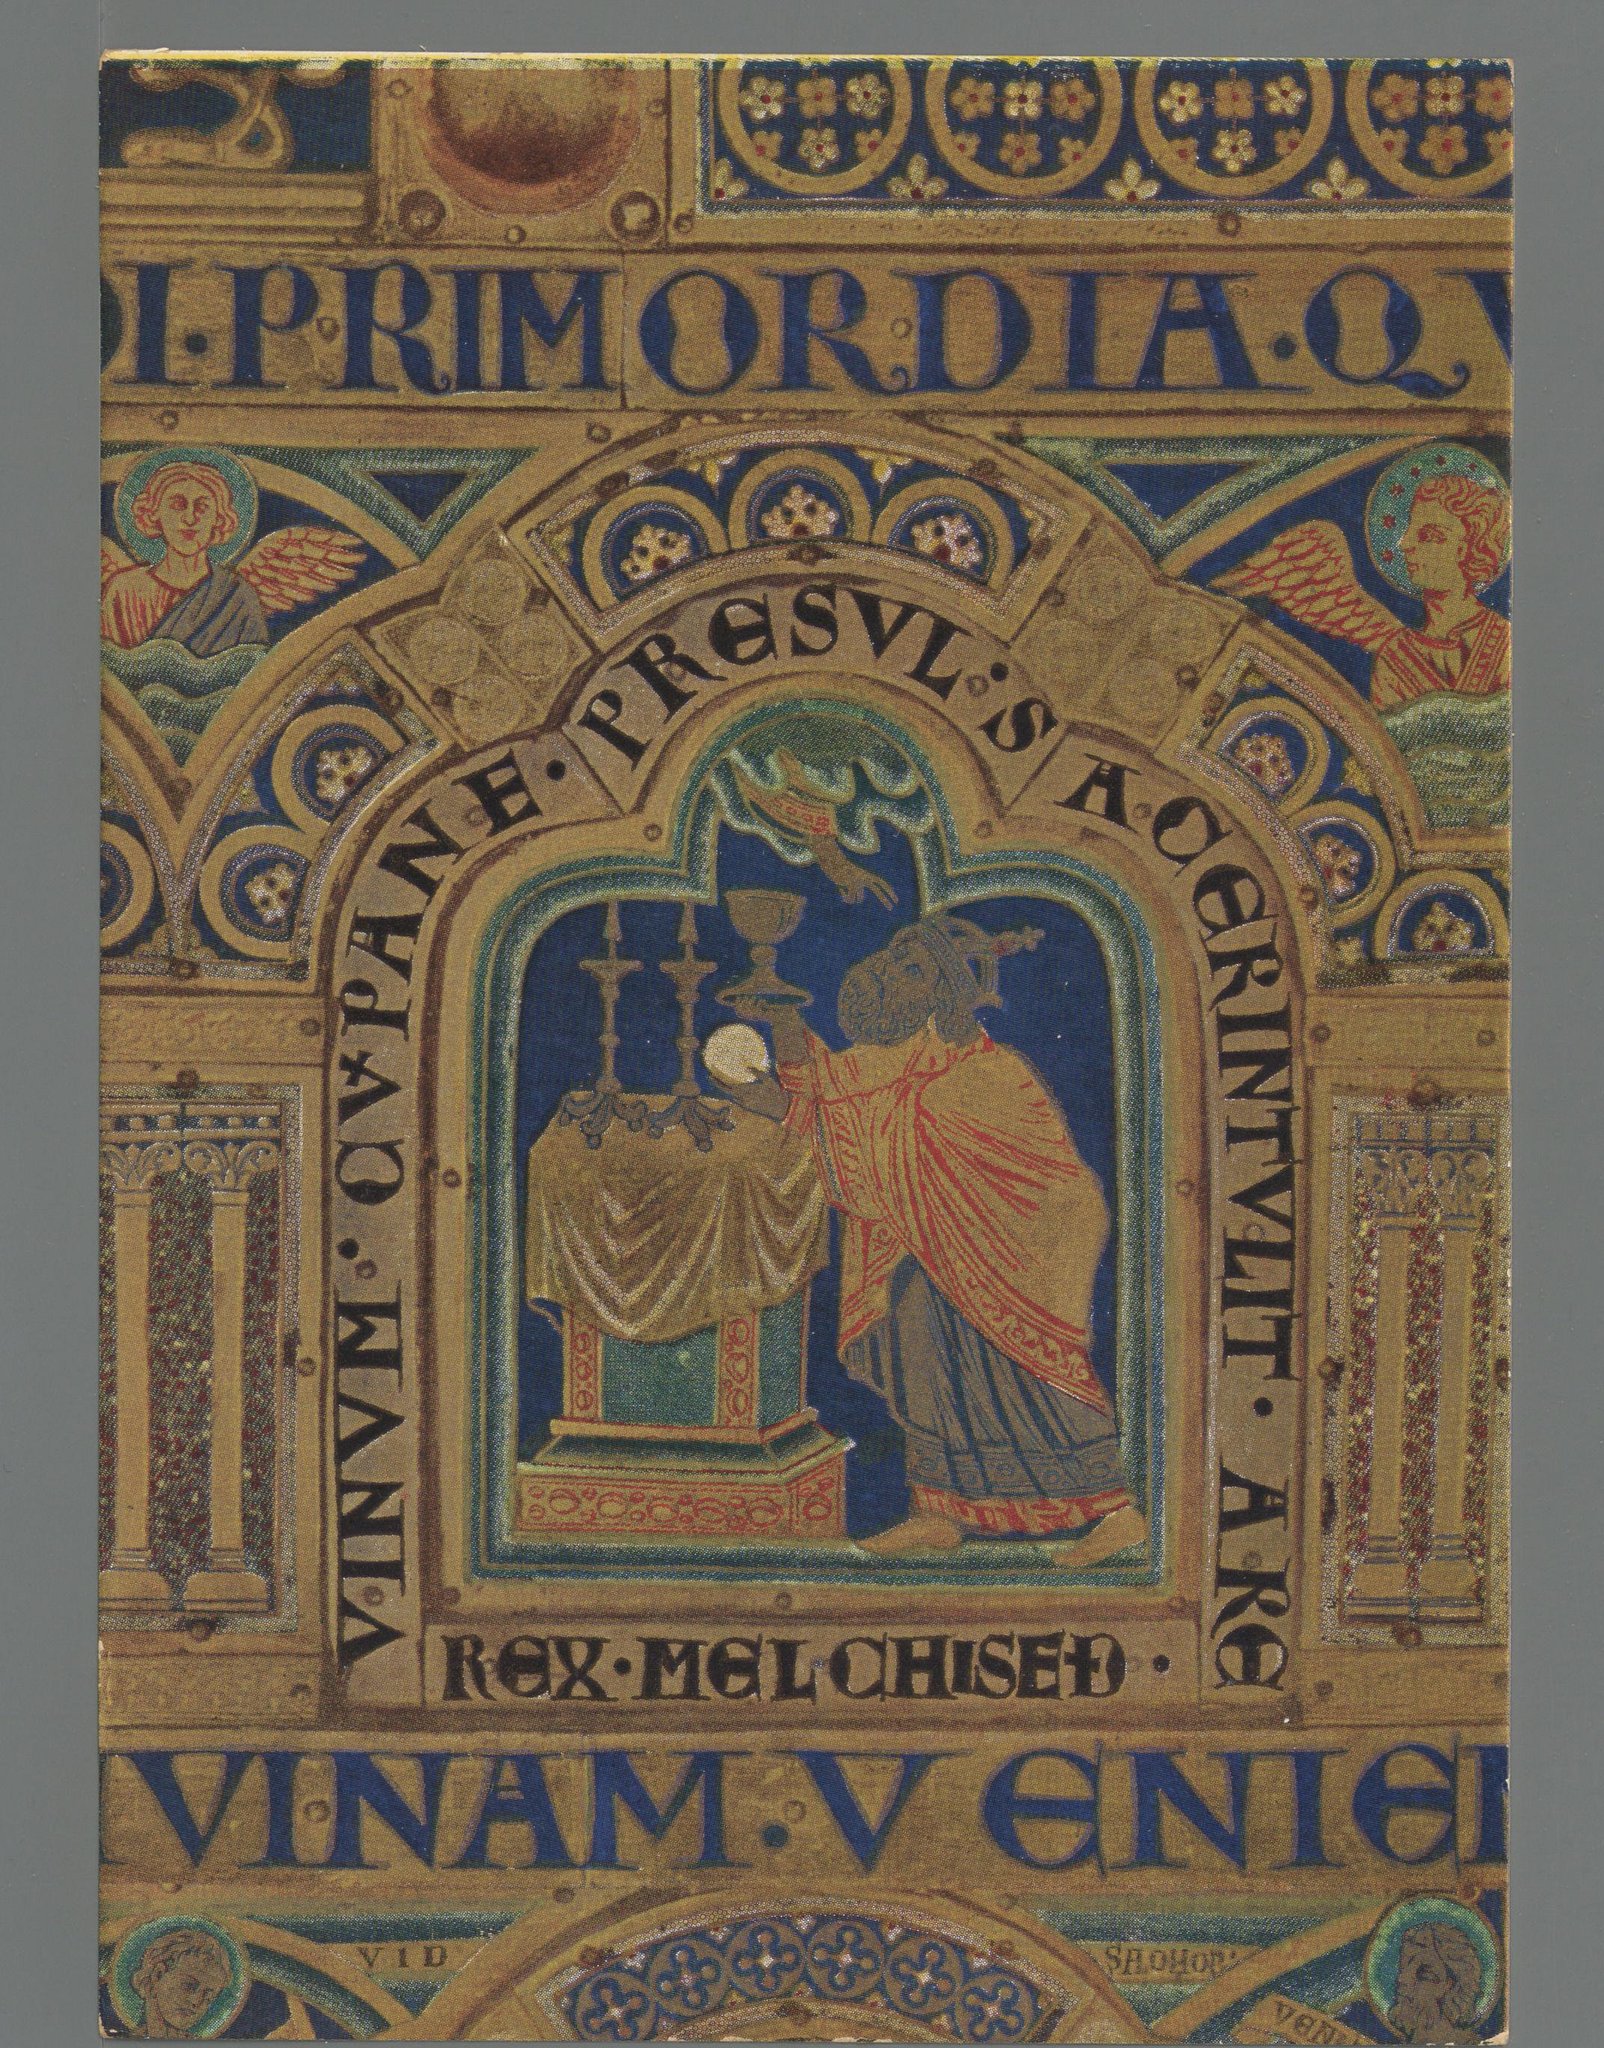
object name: ansichtkaart, prentbriefkaart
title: Der berühmte Verduner-Altar von Klosterneuburg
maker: Anonymous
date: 1927-1955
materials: cardboard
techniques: printing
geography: klosterneuburg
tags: interior of church, altar with altar-piece